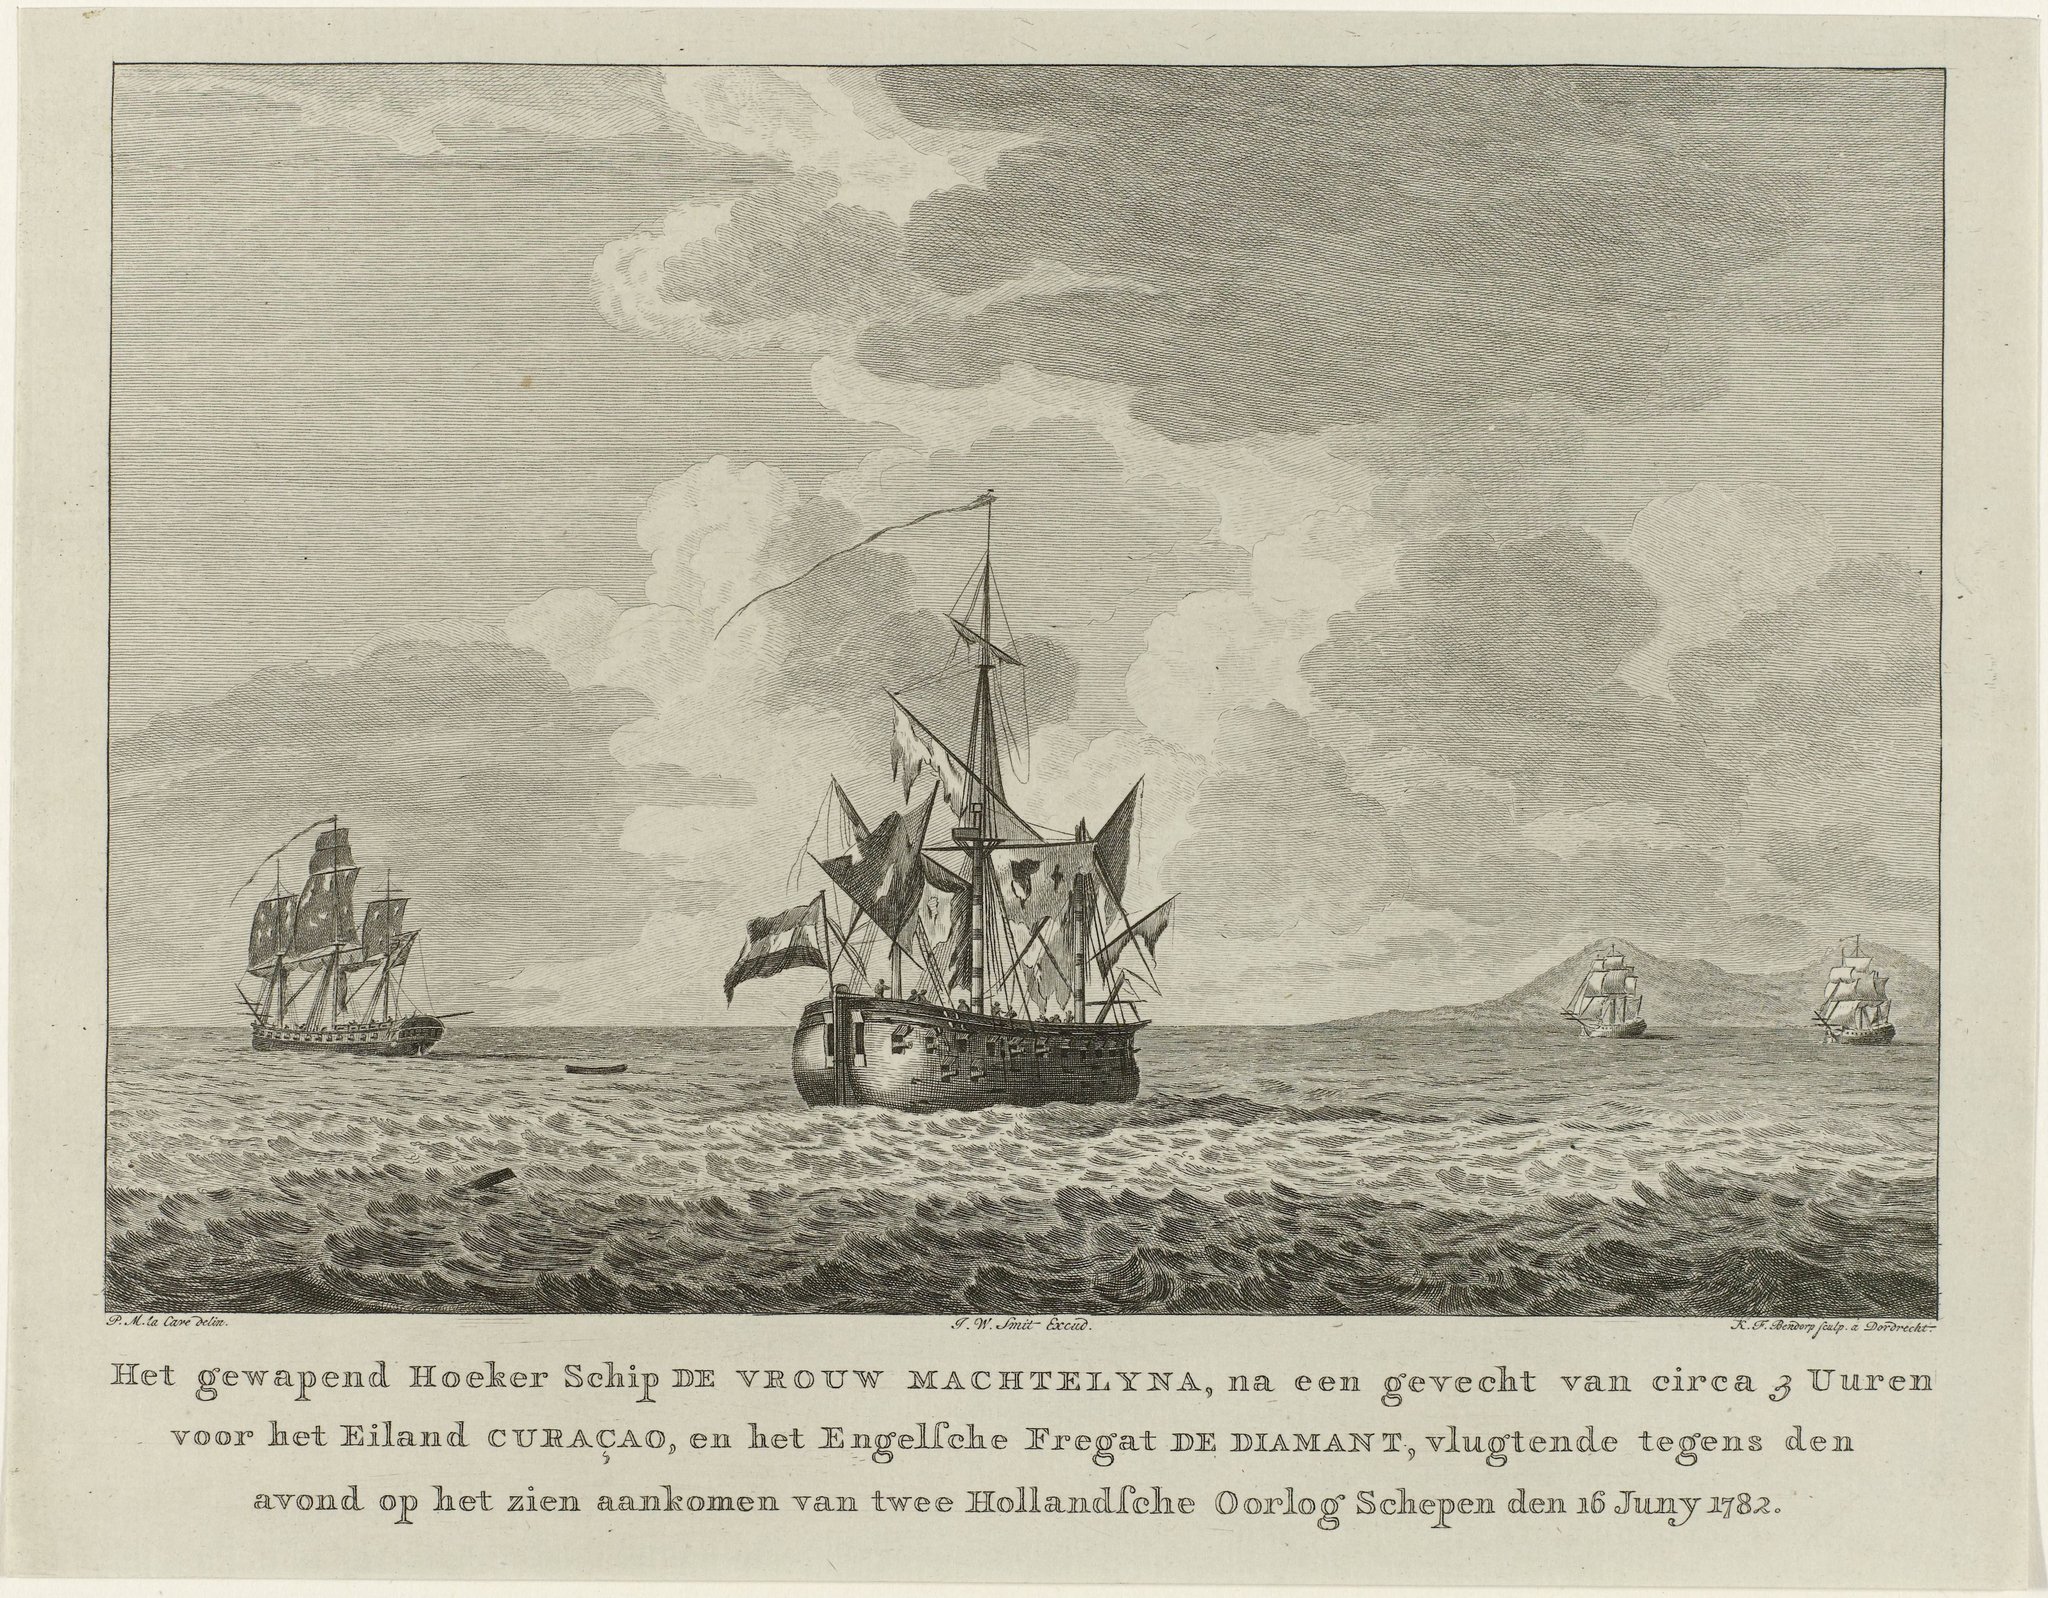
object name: print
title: Drie platen van het hoekerschip Vrouw Machtelyna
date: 1782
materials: paper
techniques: engraving, etching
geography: amsterdam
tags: battle (+ naval force), fourth anglo-dutch war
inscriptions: collector's mark: Lugt 2228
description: Het Nederlandse gewapende hoekerschip de Vrouw Machtelyna na het gevecht met het Engelse fregat de Diamant, voor Curaçao op 16 juni 1782. Het Engelse oorlogsschip vlucht na de komst van twee Nederlandse oorlogsschepen. Onderdeel van een serie van drie platen van het gevecht van het hoekerschip Vrouw Machtelyna met het Engelse fregat Diamant voor de haven van Curaçao op 16 juni 1782. Bij deze prentserie behoort een aankondiging van de uitgever.